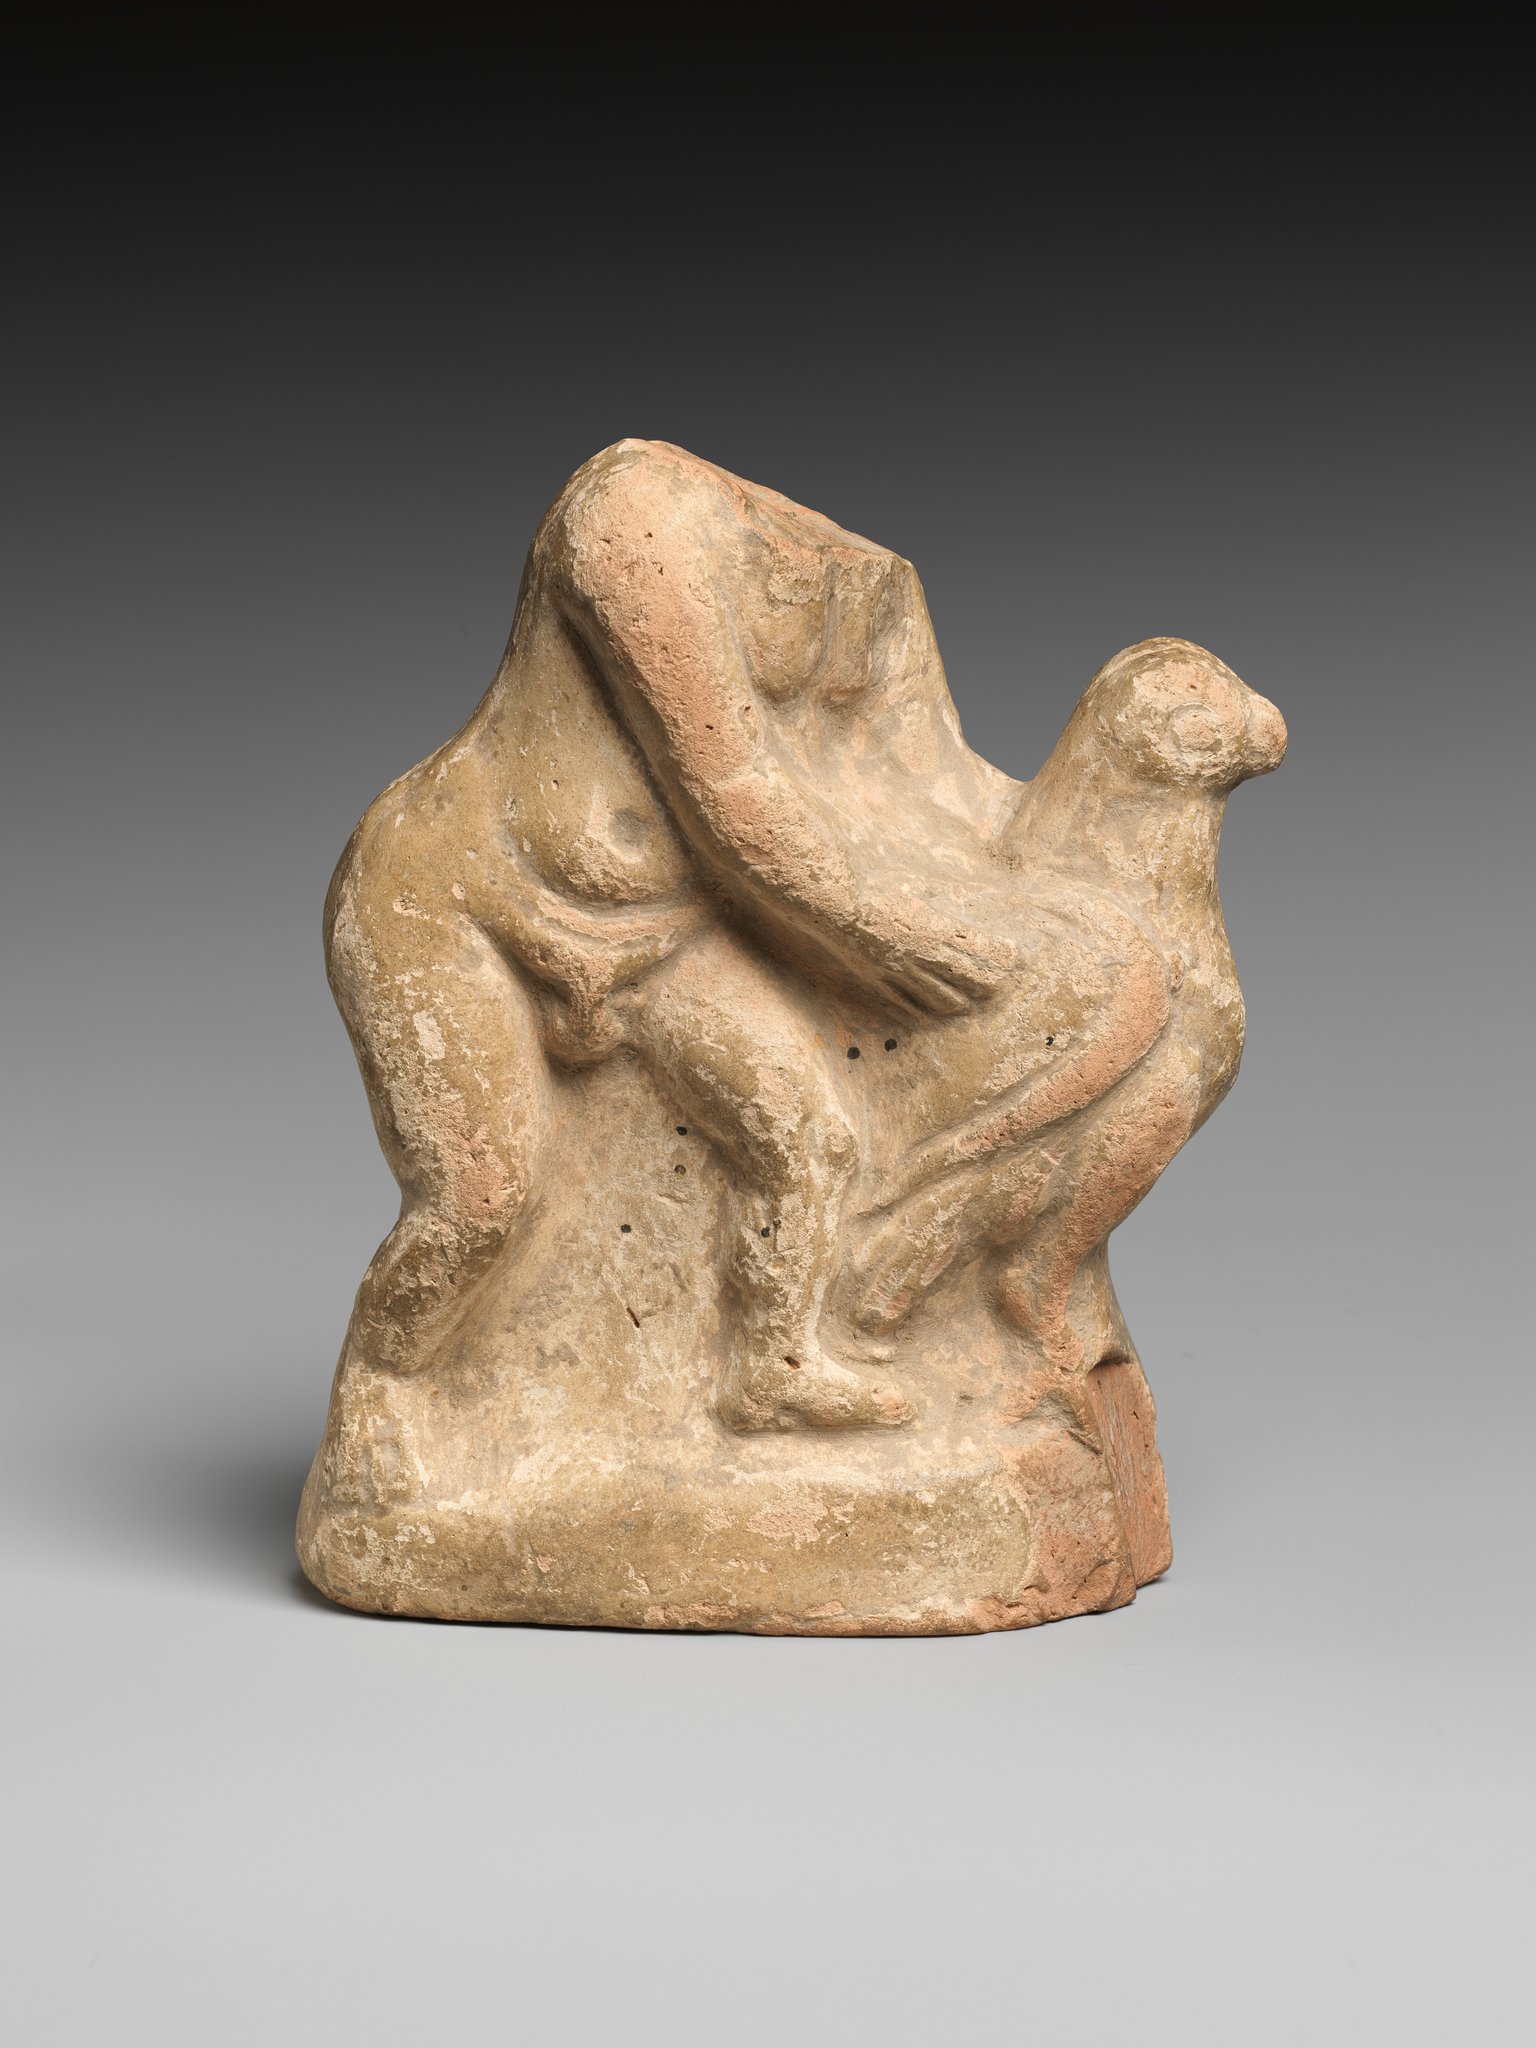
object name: sculpture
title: Figure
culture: parthian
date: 1-200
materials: ceramic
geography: mesopotamia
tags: birds,male nudes